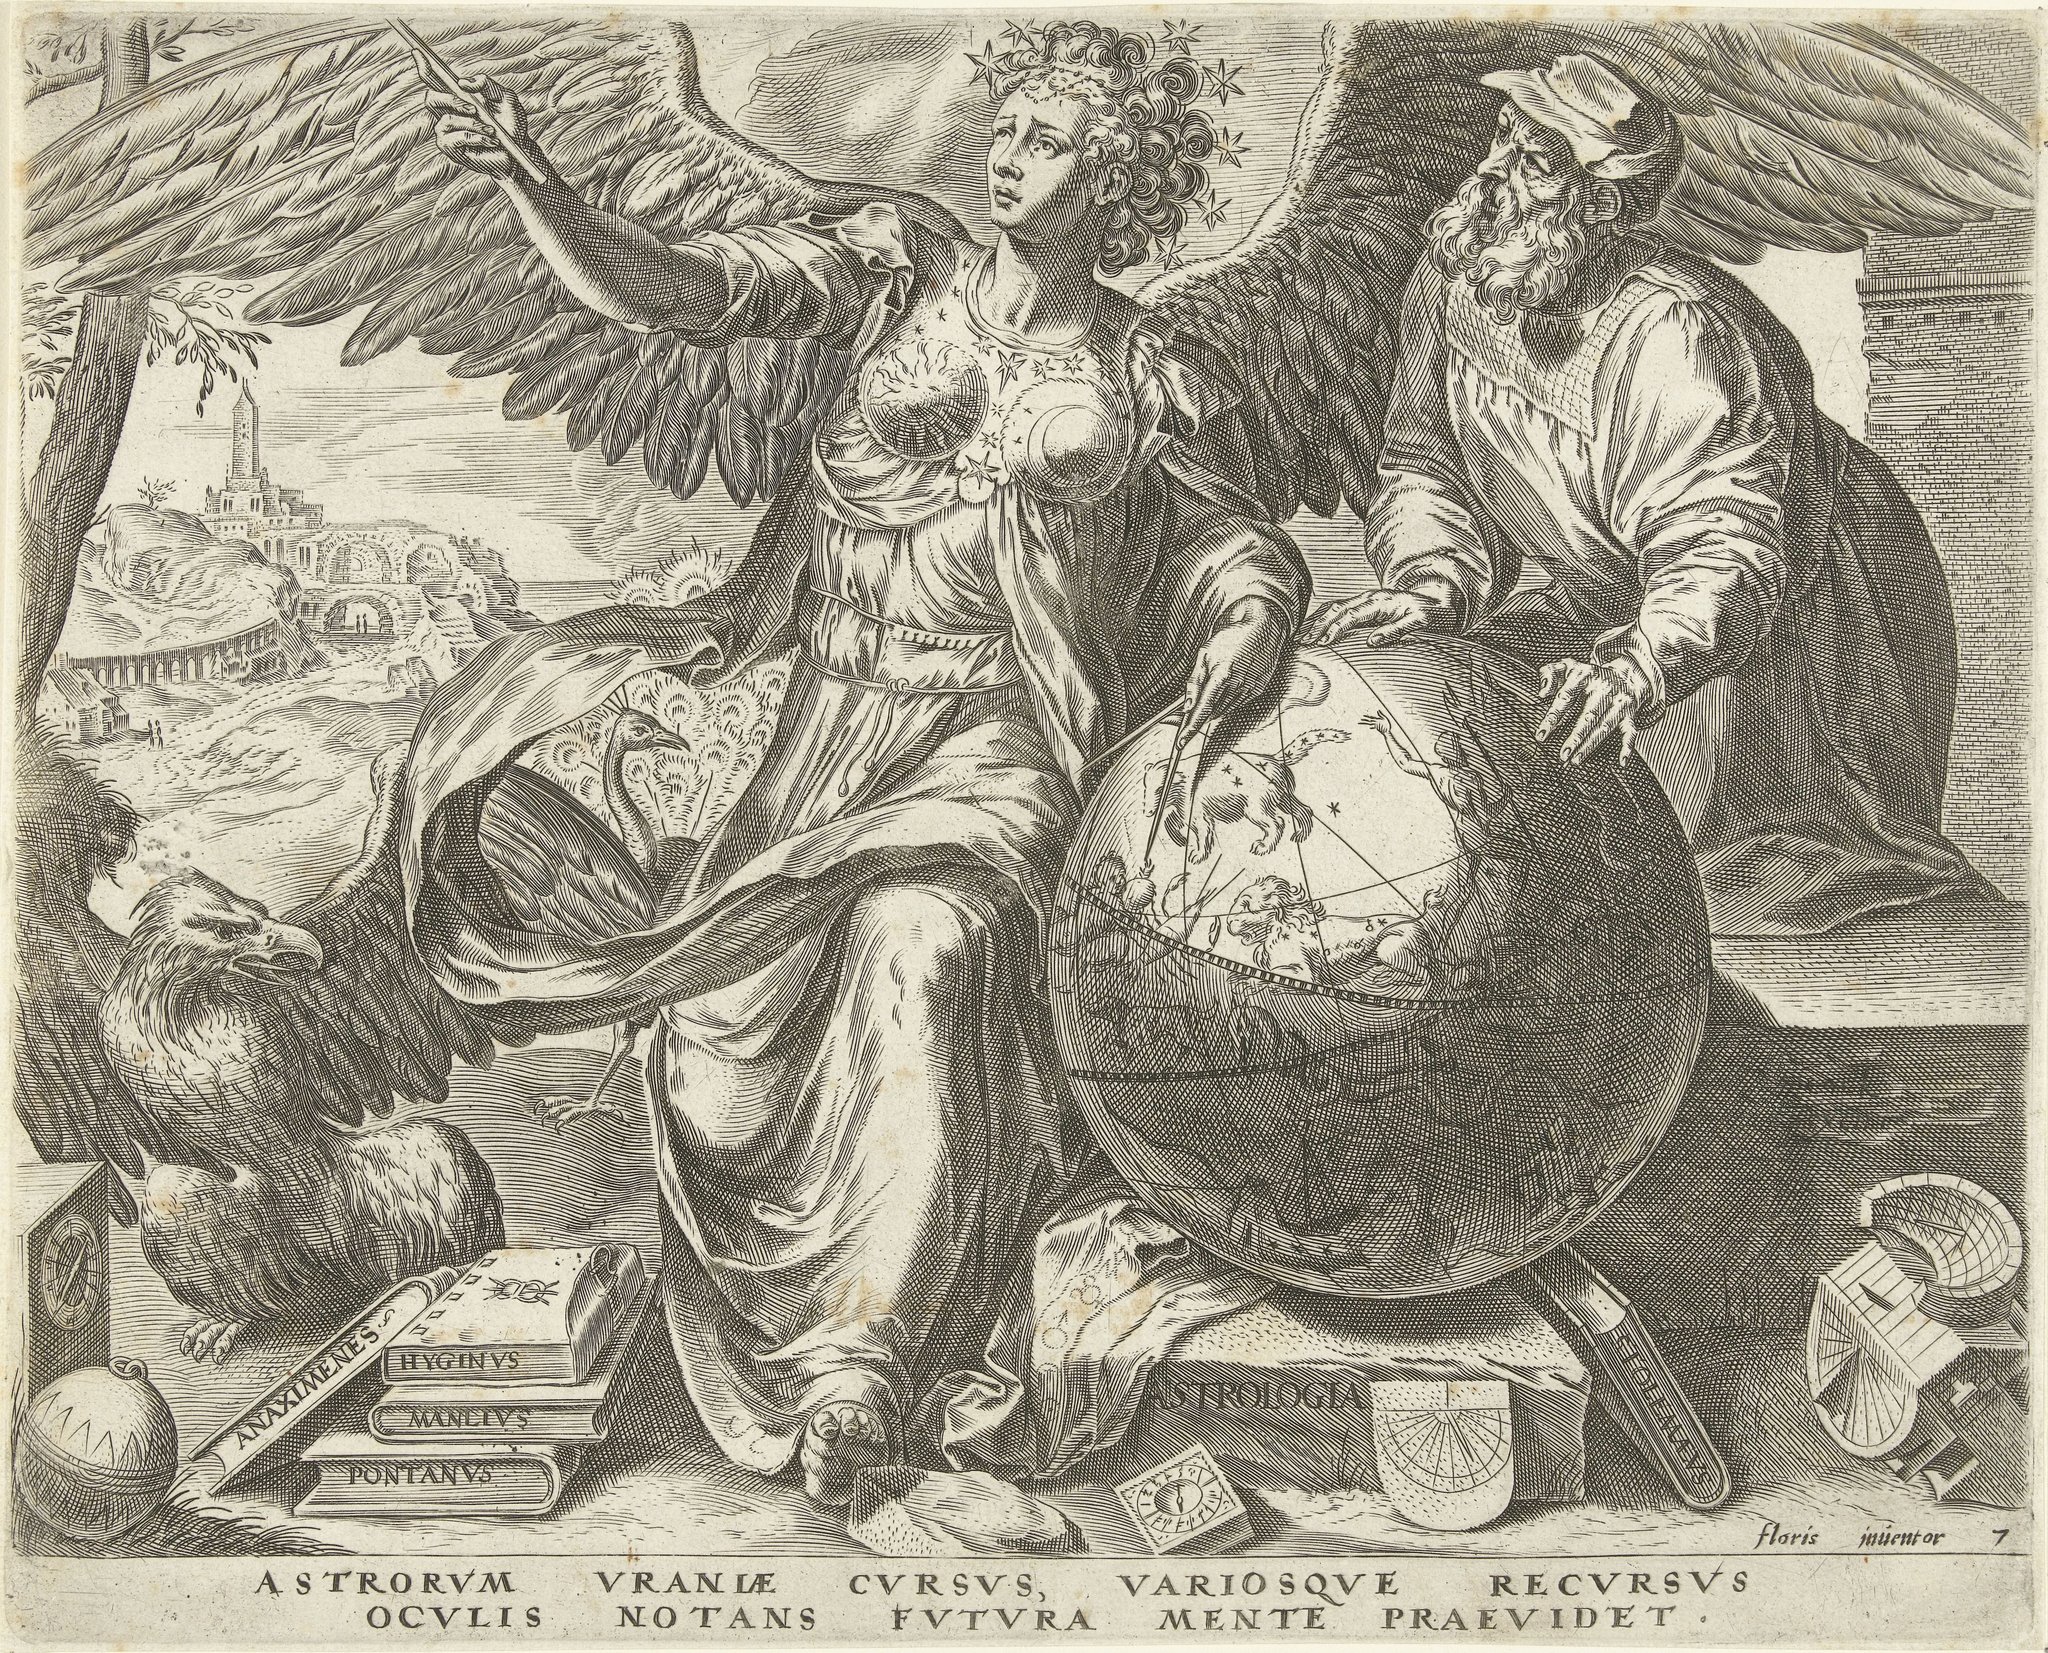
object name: print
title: Astrologia (Sterrenkunde)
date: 1565-1600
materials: paper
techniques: engraving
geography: antwerp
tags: 'astronomia' (~ quadrivium); 'astronomia' (ripa)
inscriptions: collector's mark: Lugt 2228, caption:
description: Astrologia , een gevleugelde vrouw met een sterrenkrans om het hoofd, meet de afstand tussen de sterrenbeelden met een passer op een hemelglobe. Haar blik is visionair richting hemel gericht. Een oude man met baard die naast haar staat kijkt dezelfde kant op. Op de grond liggen boeken en astrologische instrumenten. Achter Astrologia zit een pauw en rechts naast haar staat een adelaar.